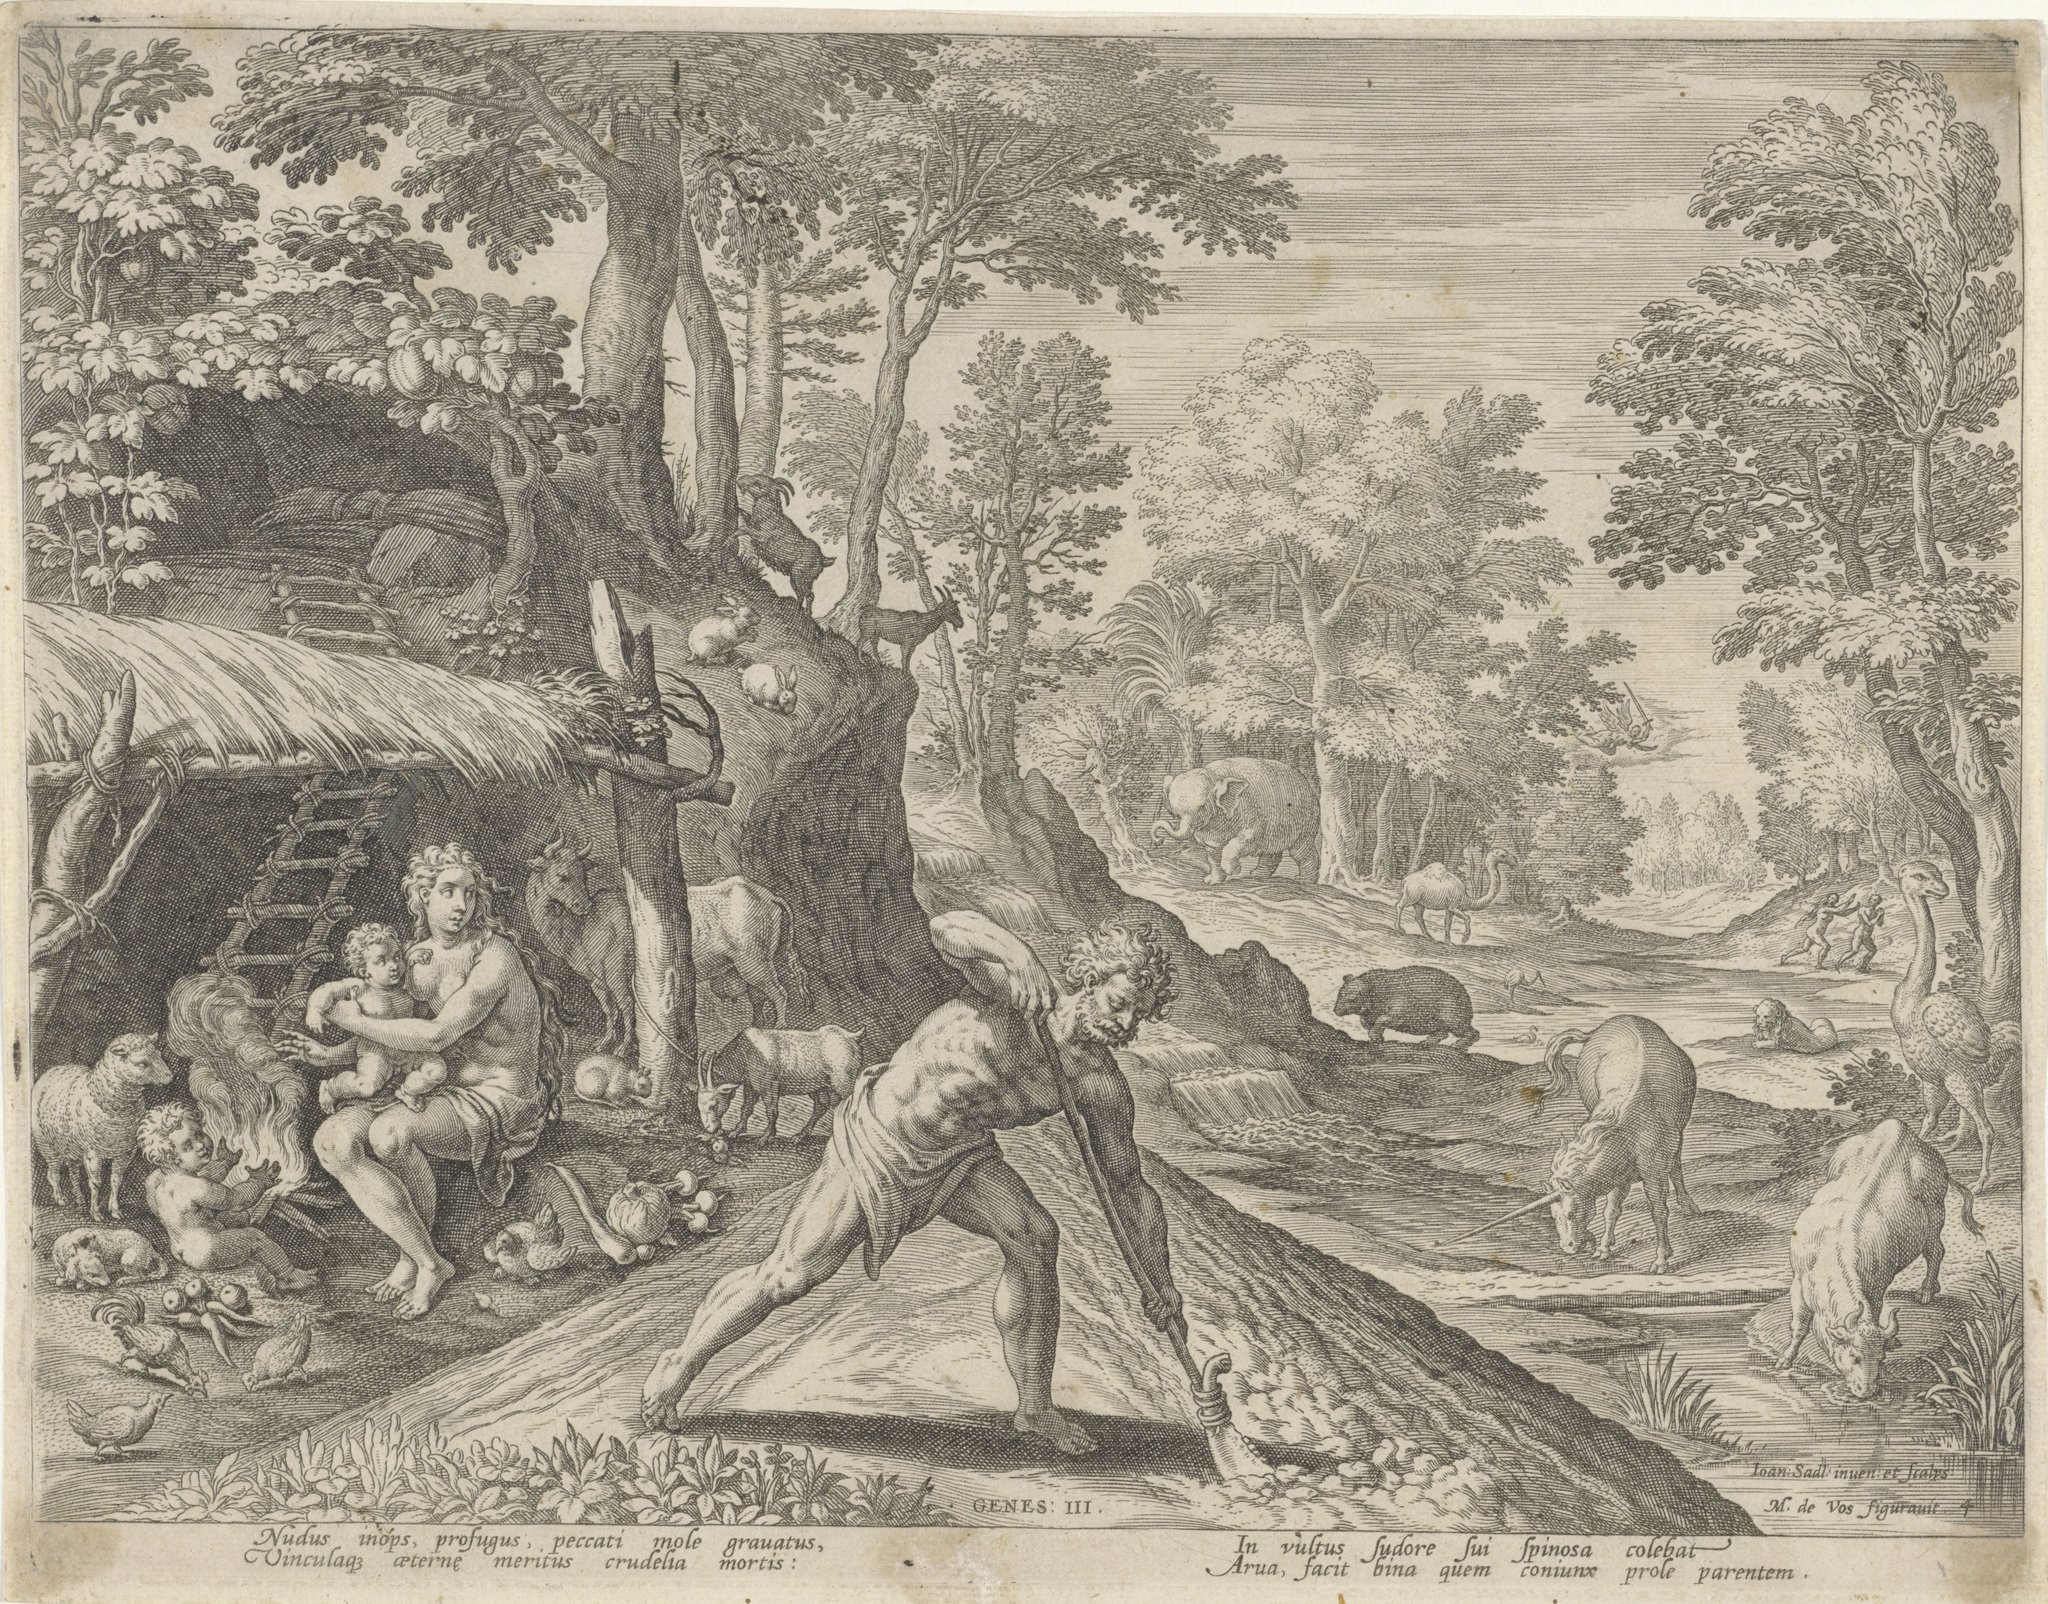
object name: print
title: Adam en Eva aan het werk buiten het Aards Paradijs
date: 1583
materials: paper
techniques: engraving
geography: antwerp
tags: adam (and eve) engaged in agricultural activities, the labours of adam and eve; infancy of cain and abel (genesis 4:1-2), spading ~ soil cultivation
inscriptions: collector's mark: Lugt 2228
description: Adam en Eva en hun kinderen Kaïn en Abel in de wildernis buiten het Aards Paradijs. Adam bewerkt de grond terwijl Eva Abel de borst geeft. Kaïn warmt zich aan het vuur. Rondom hen verschillende dieren. De prent heeft een Latijns onderschrift.